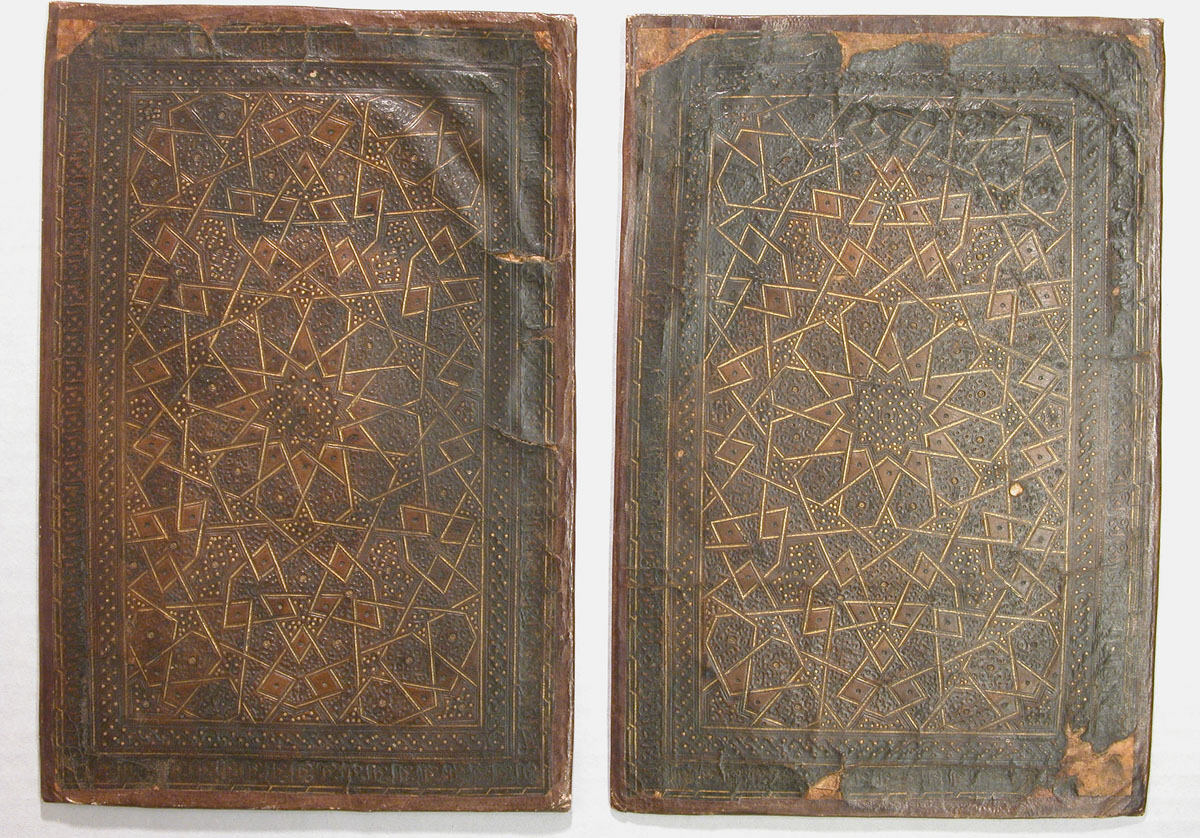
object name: bookbinding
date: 1301-1400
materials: gold, leather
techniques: stamping, tooling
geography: egypt or syria